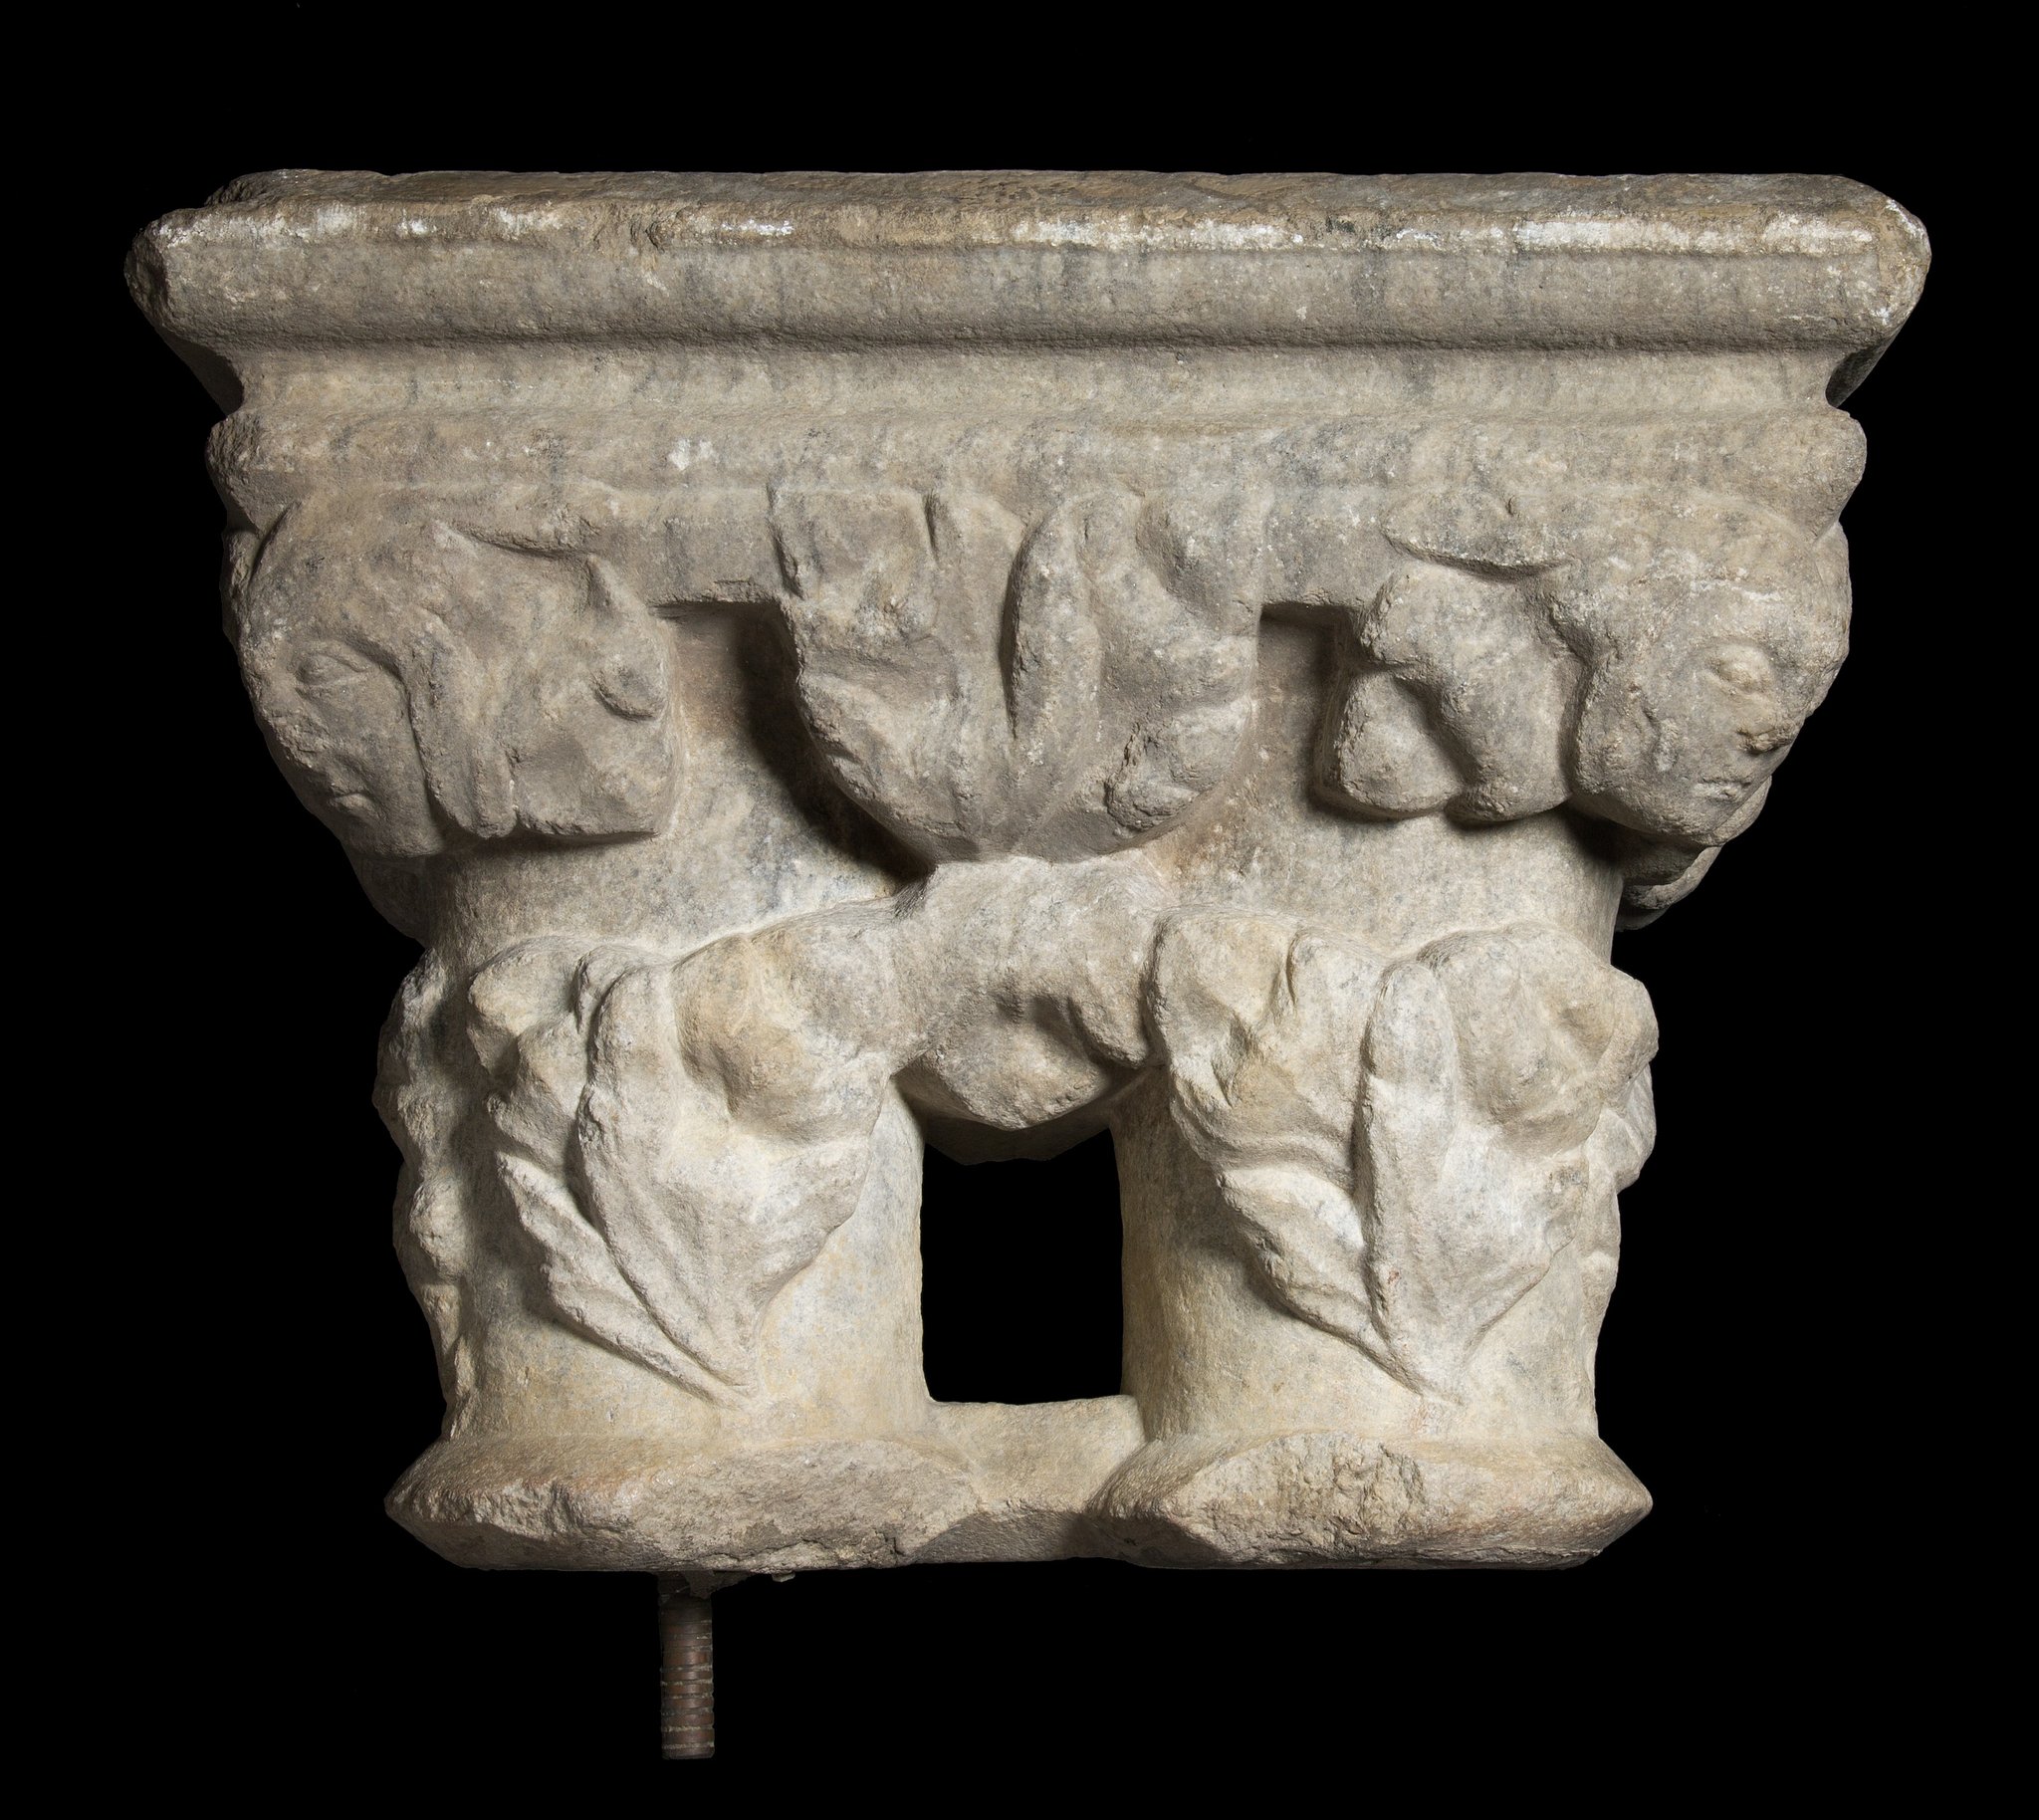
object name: double column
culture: french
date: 1201-1400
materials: marble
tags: heads